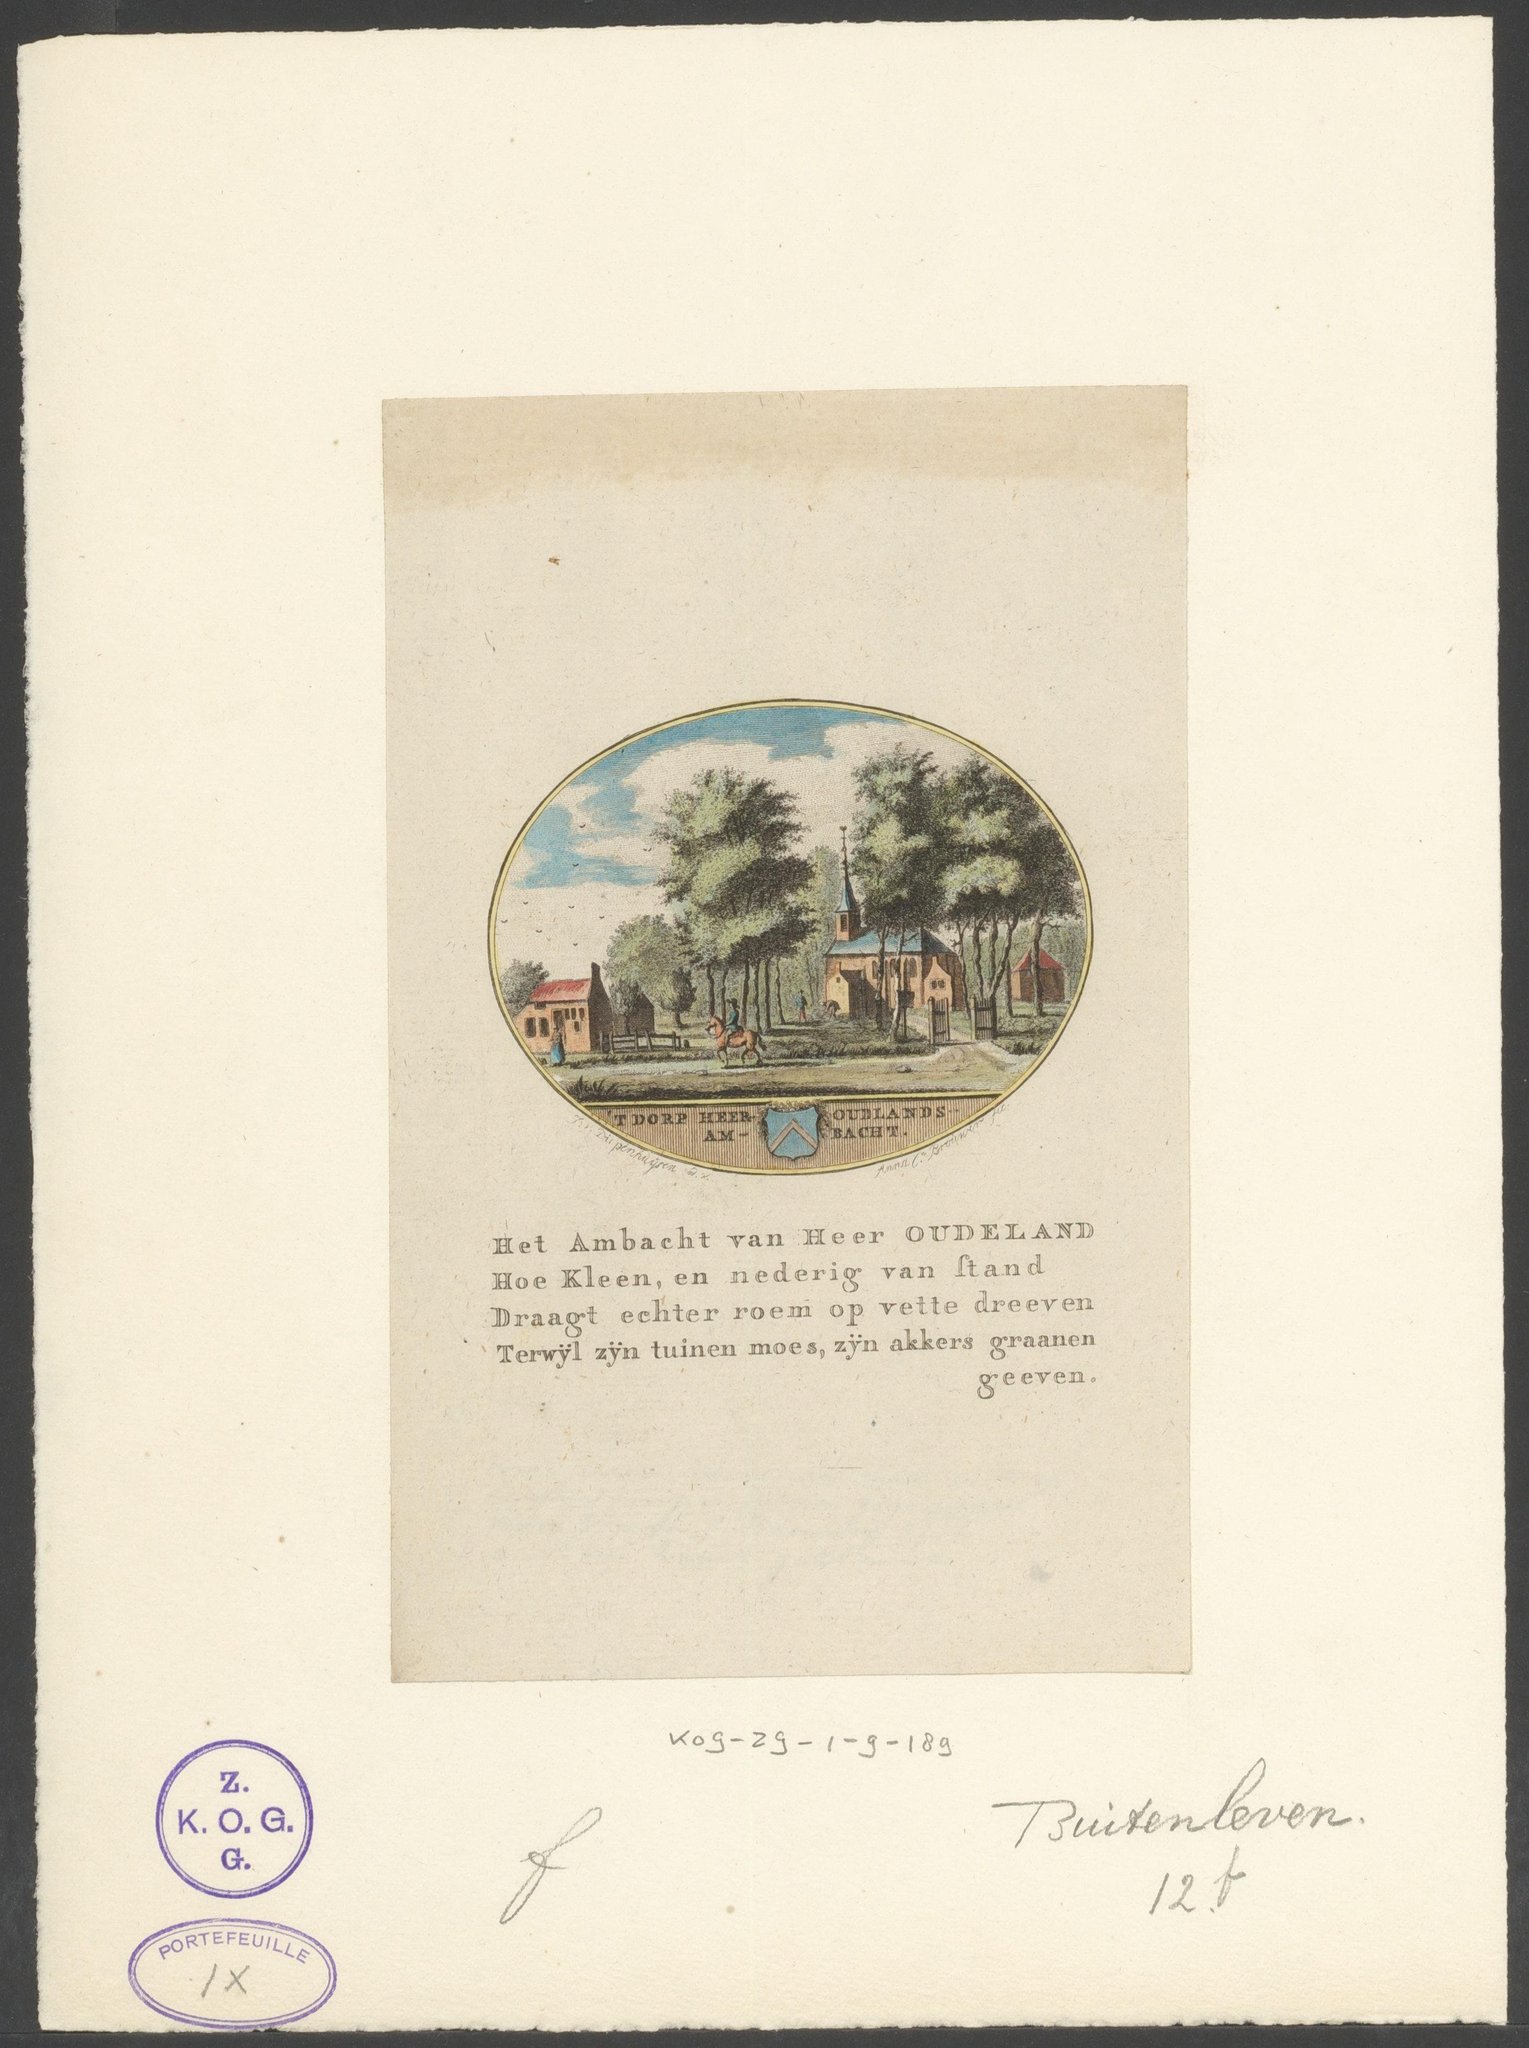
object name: print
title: Gezicht op Heer-Oudelands-Ambacht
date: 1791-1793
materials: paper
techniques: etching, hand coloring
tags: heer-oudelands-ambacht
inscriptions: stamp, collector's mark: Lugt 1641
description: Gezicht op Heer-Oudelands-Ambacht. Onderaan een vierregelig vers. Onderwerpsrubrieken binnen de Atlas Zeden en Gewoonten: Handel, nijverheid en verkeer, Buitenleven.